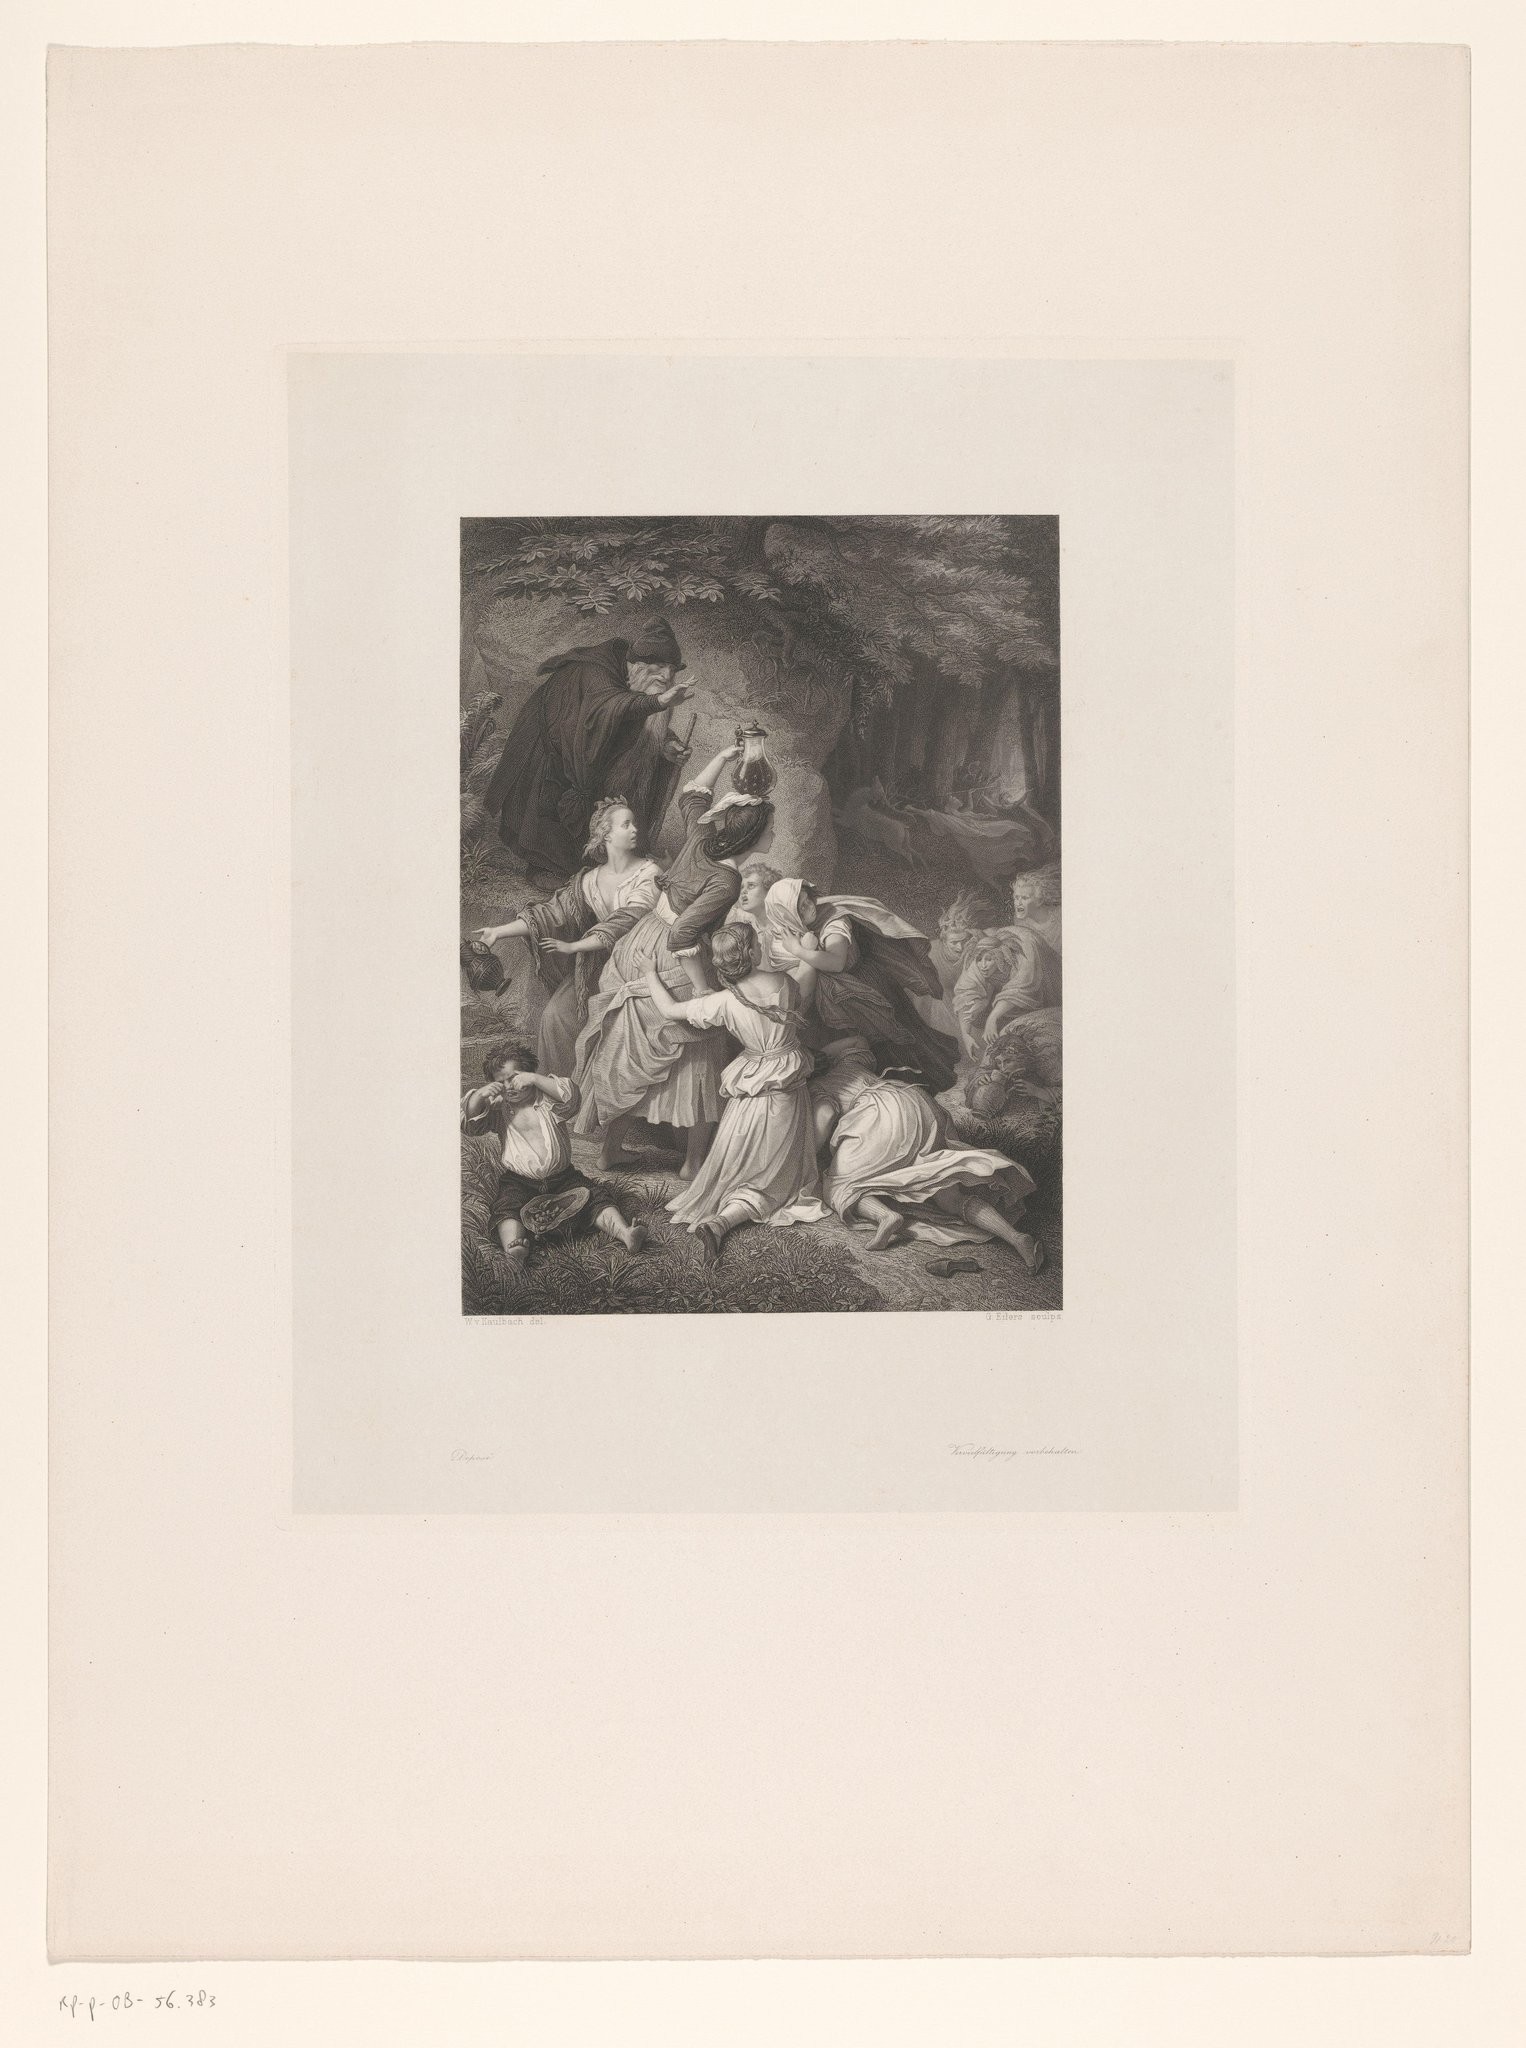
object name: print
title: Groep angstige vrouwen in een bos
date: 1861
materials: paper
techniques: etching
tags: draughtsman, johann wolfgang von goethe, specific works of literature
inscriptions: collector's mark: Lugt 2228